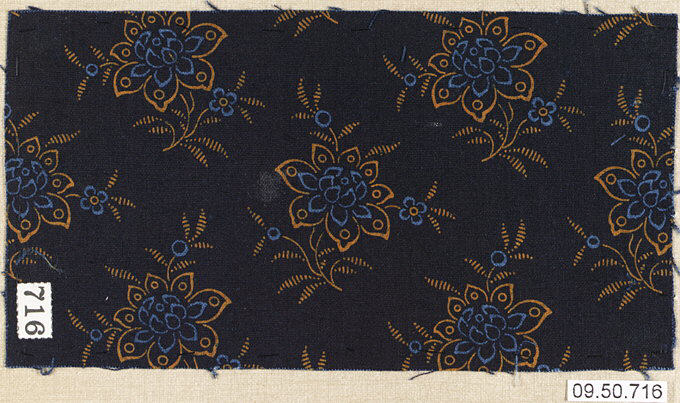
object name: piece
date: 1801-1900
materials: cotton